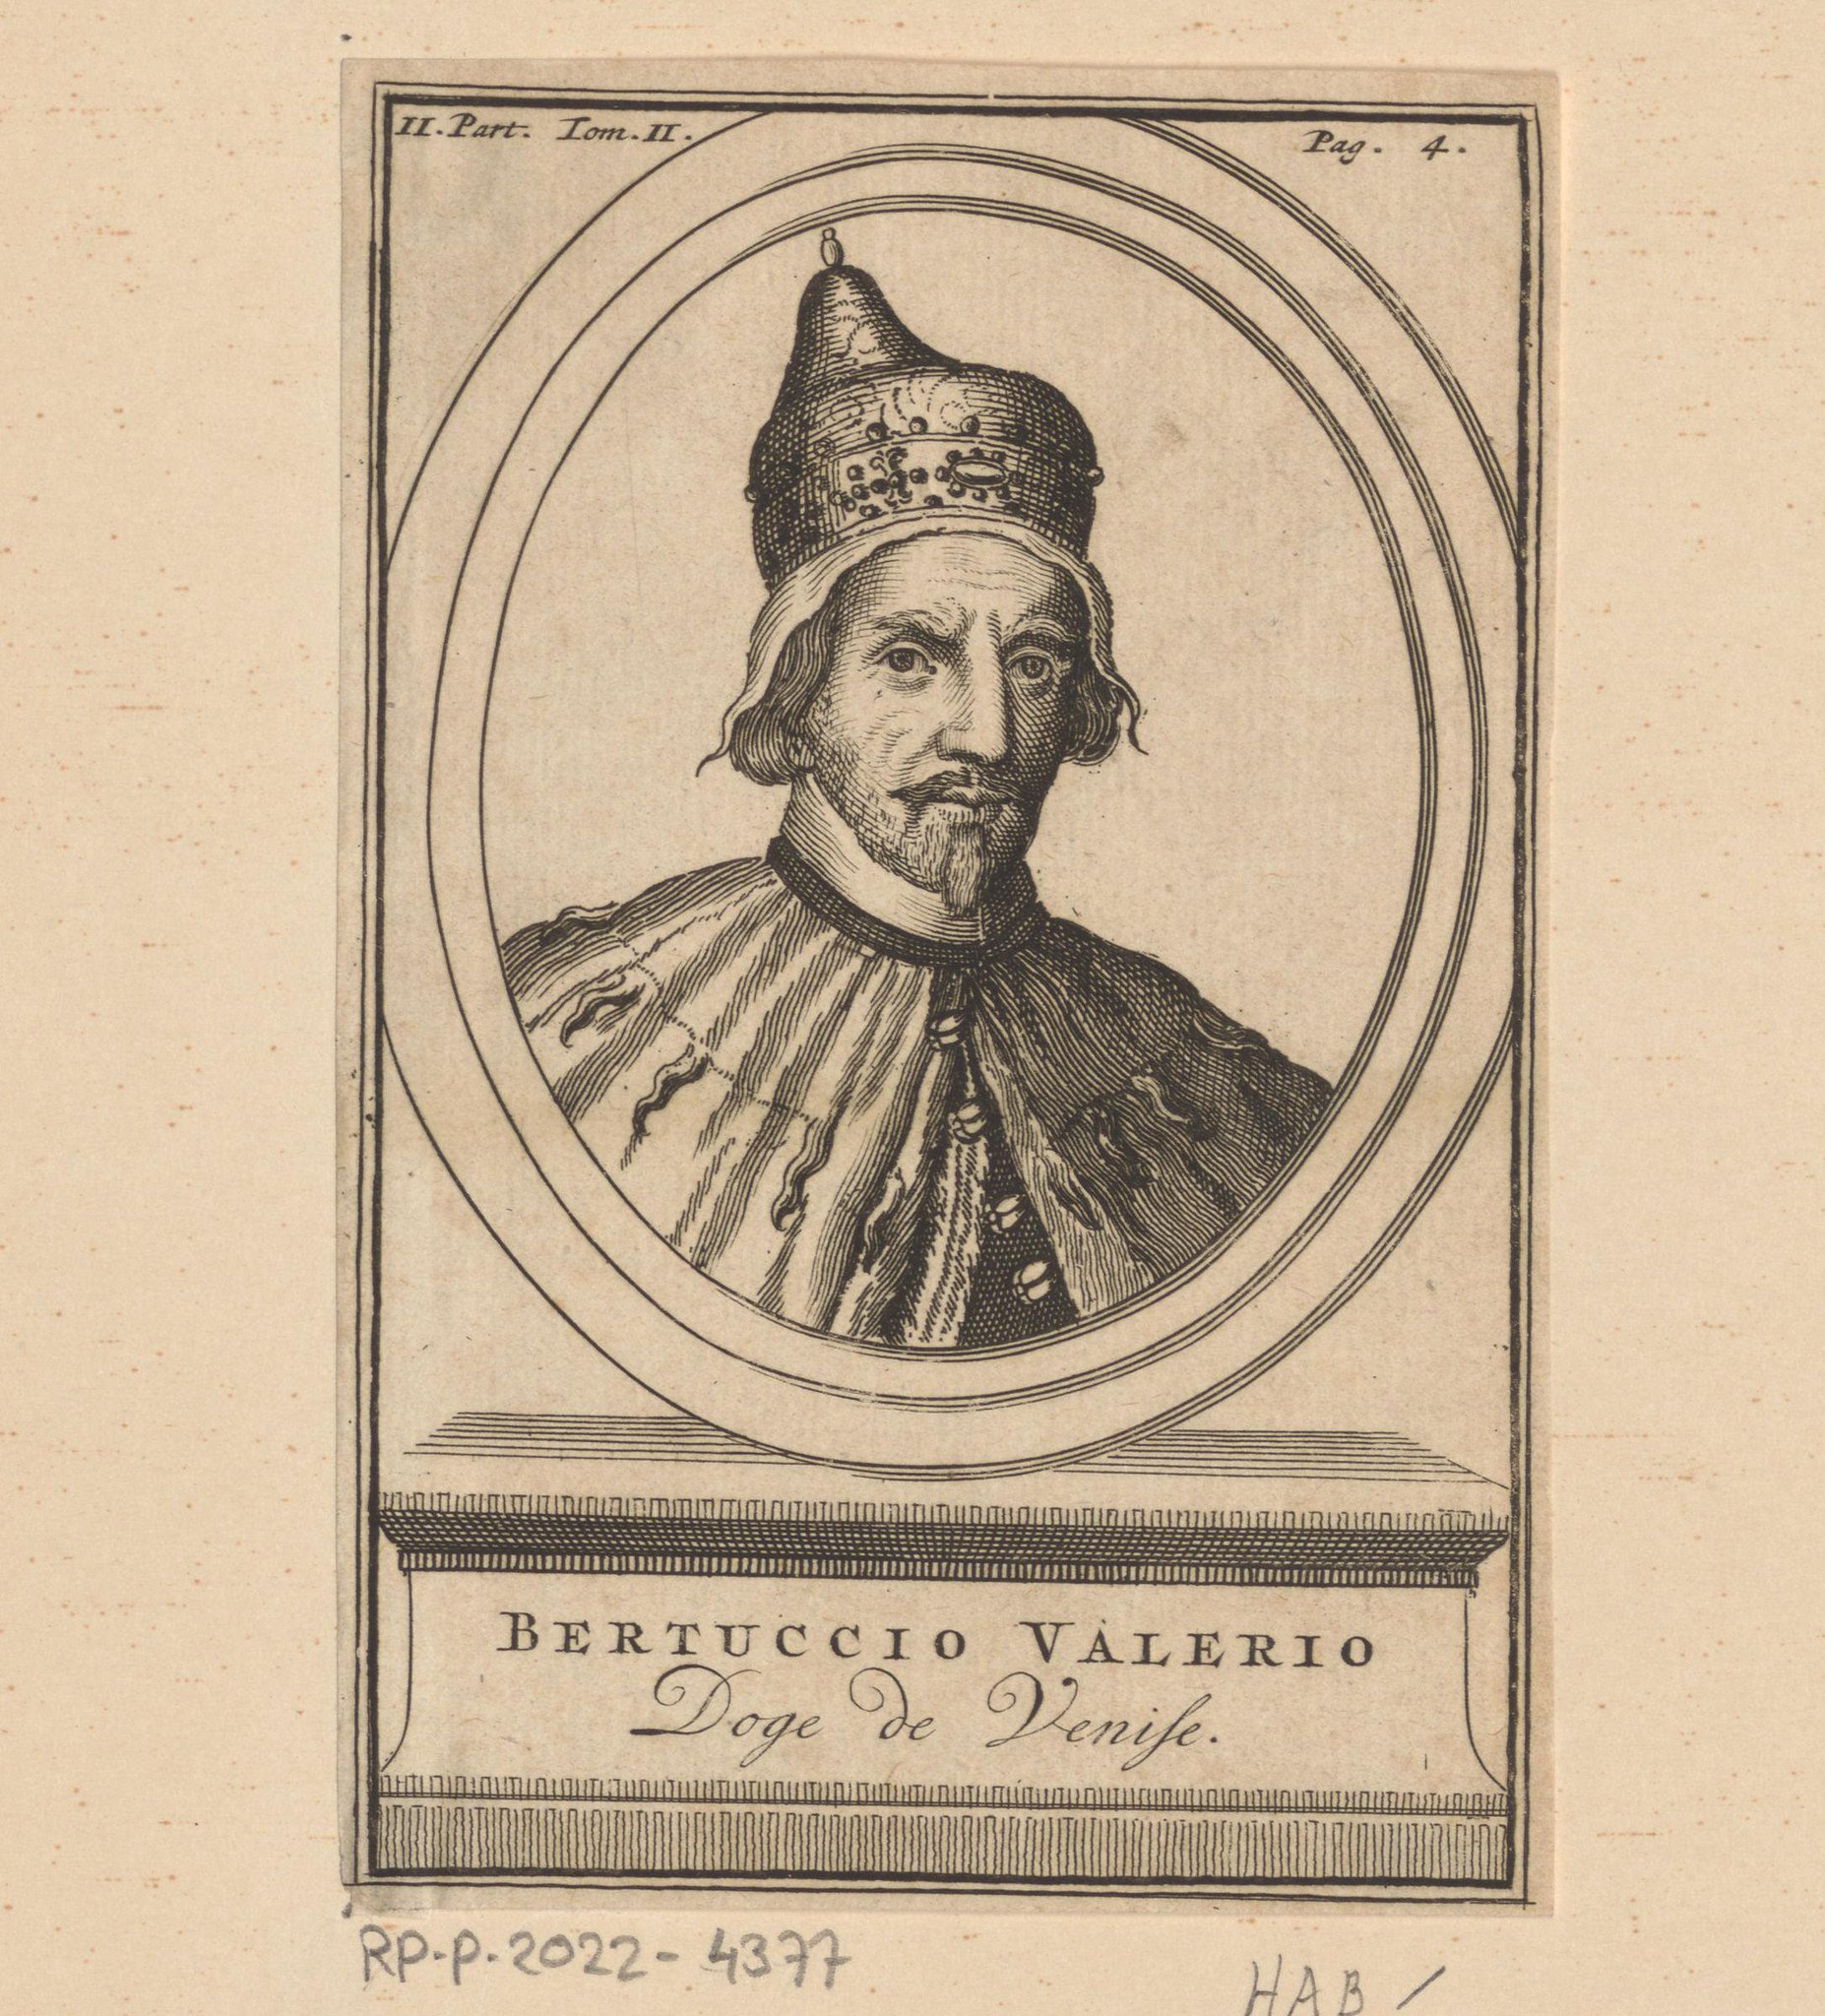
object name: print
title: Portret van Bertuccio Valiero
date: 1702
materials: paper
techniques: engraving, etching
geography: northern netherlands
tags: venice, politician, historical persons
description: Prent uit: Nani, Battista. Histoire de la République de Venise. Amsterdam: Henri Schelte, 1702, dl. 2, p. 4.